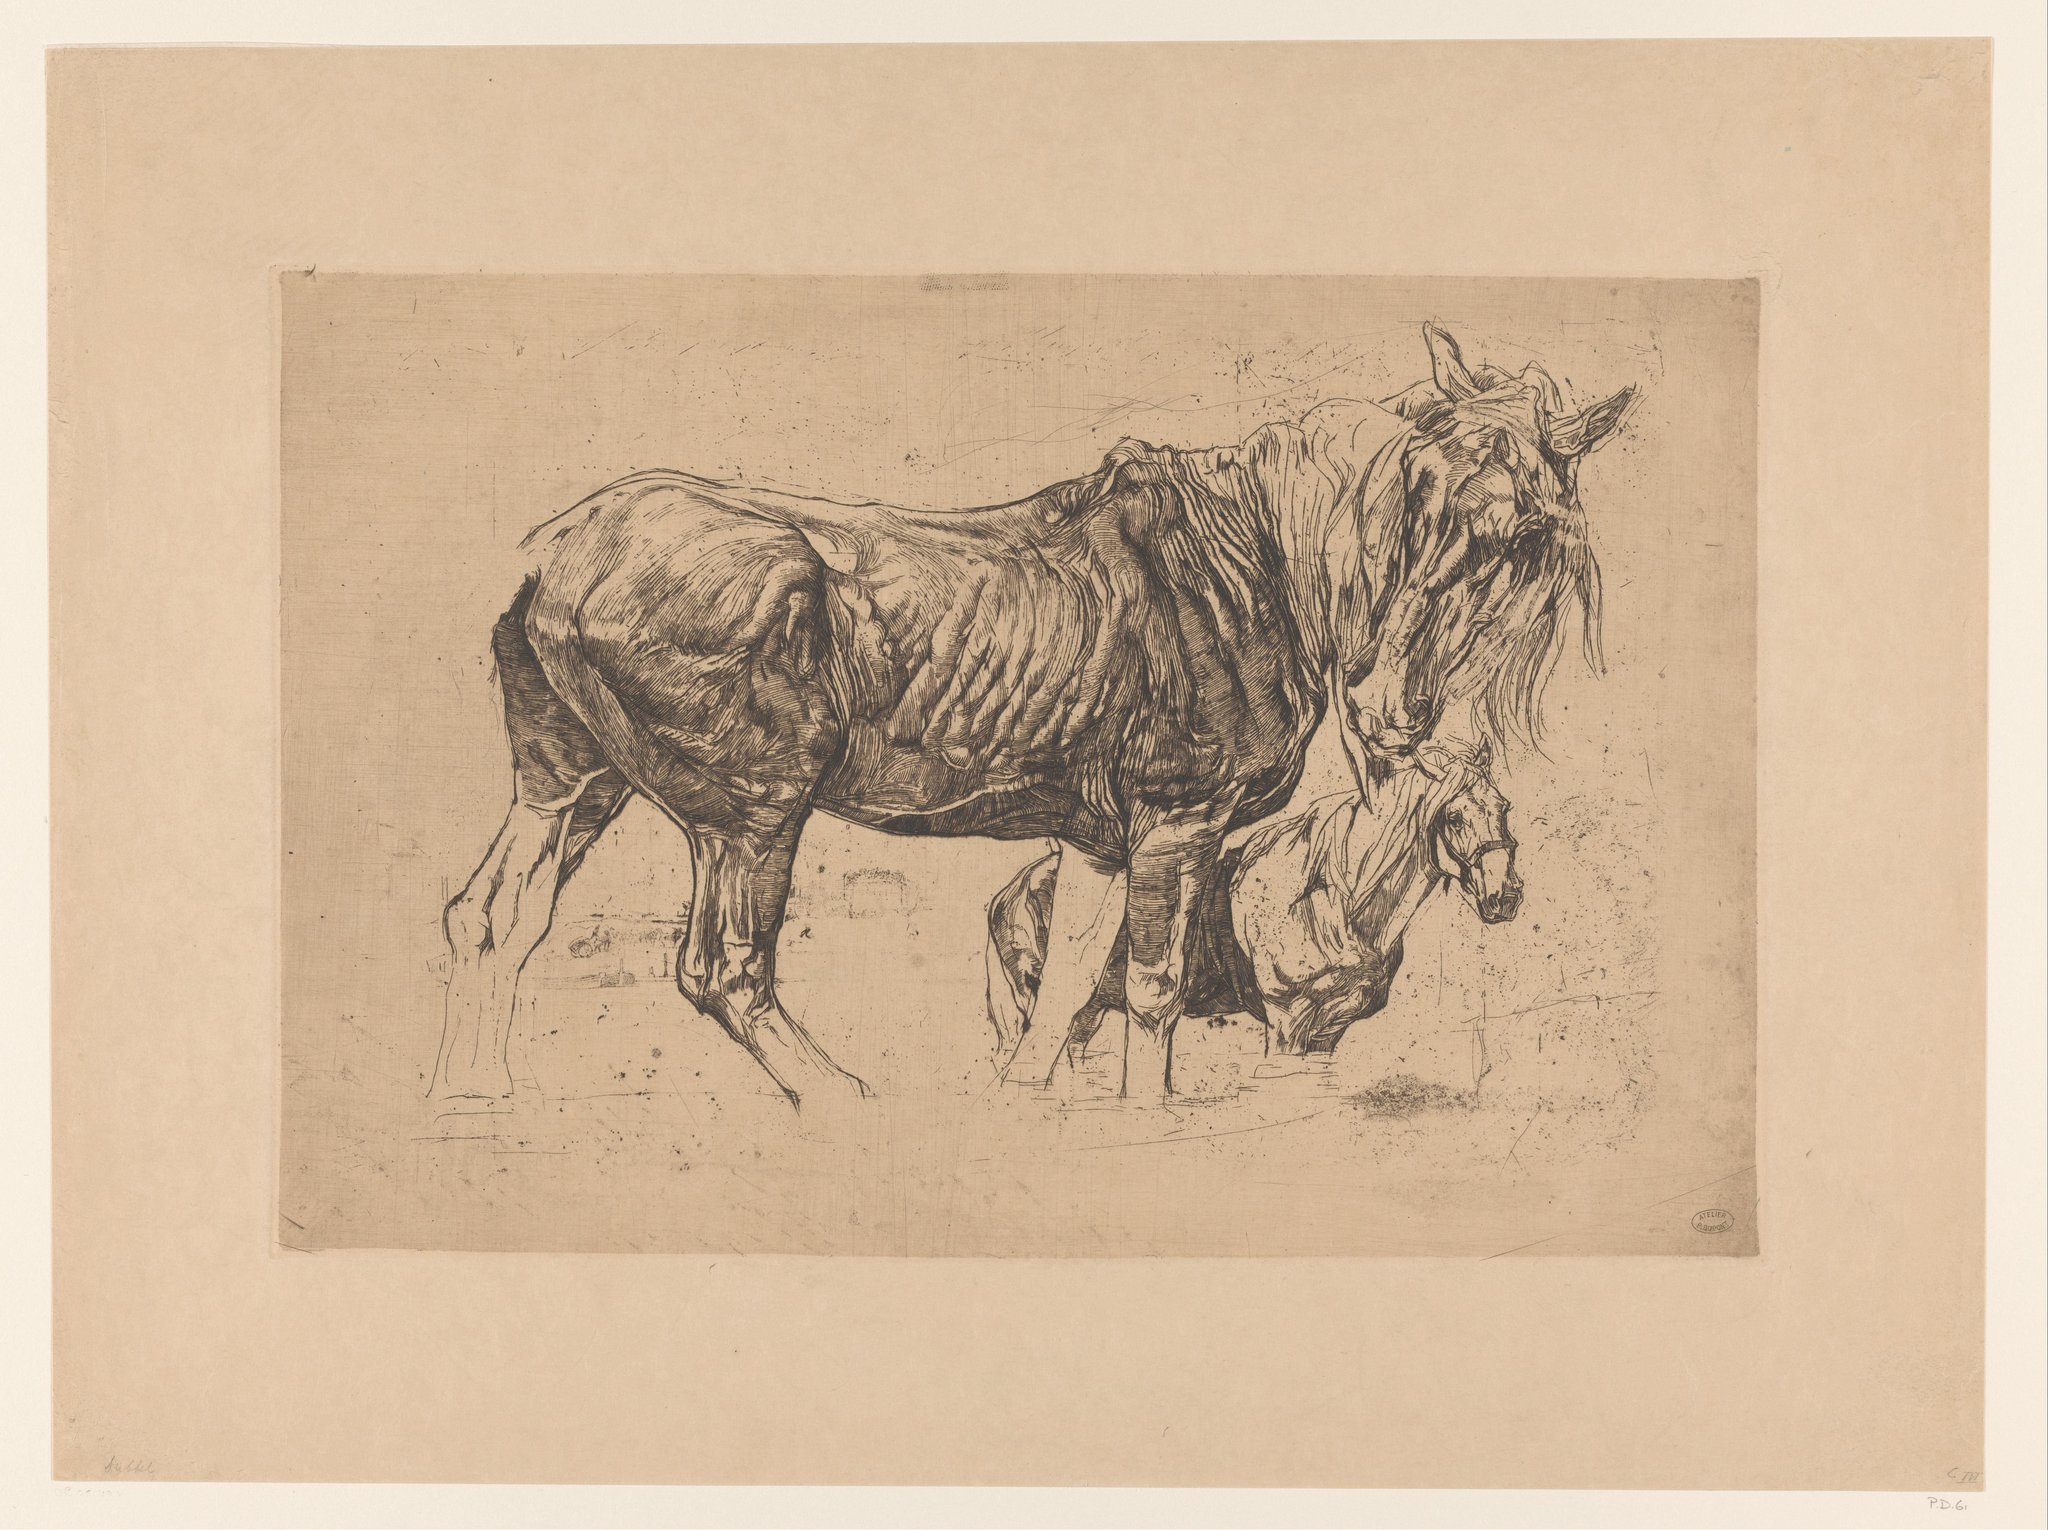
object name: print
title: Twee paarden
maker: pieter dupont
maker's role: draughtsman, print maker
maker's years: 1870-1911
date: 1897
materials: paper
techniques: etching, intaglio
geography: paris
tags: horse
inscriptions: inscription: ‘dubbel / afkomstig van K. H[...]s’, workshop stamp: Lugt 705a, collector's mark: Lugt 2228